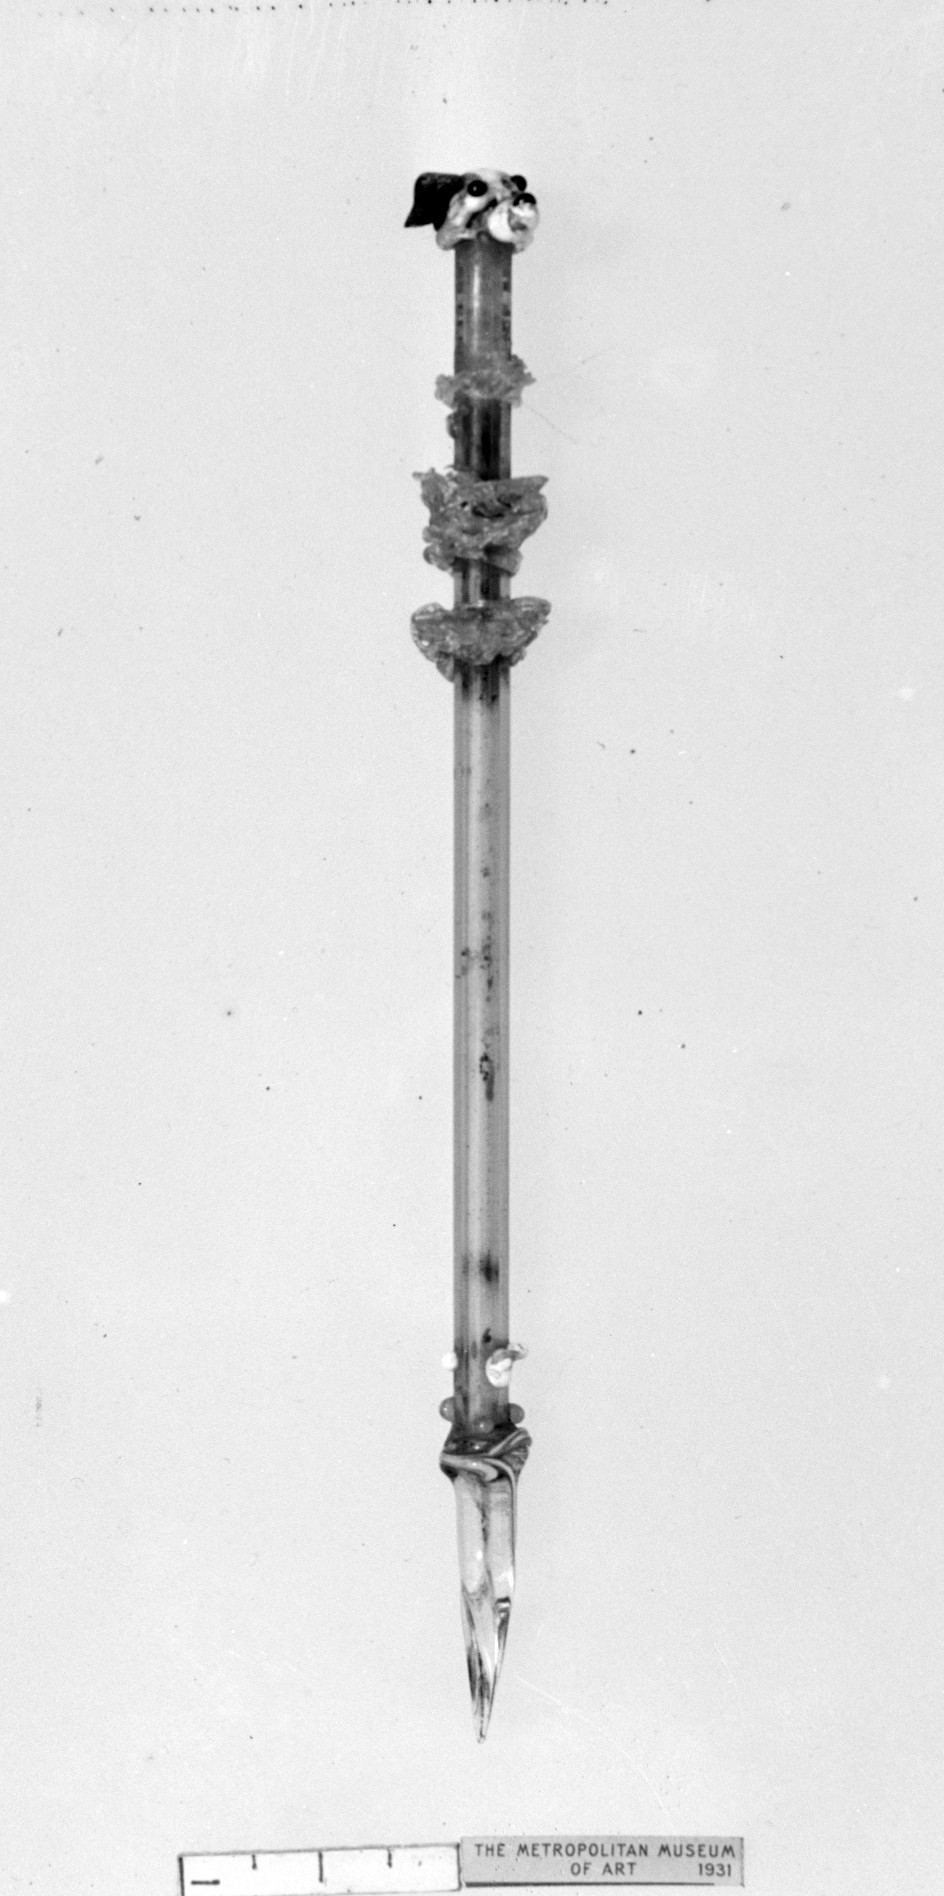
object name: pen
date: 1801-1900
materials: glass